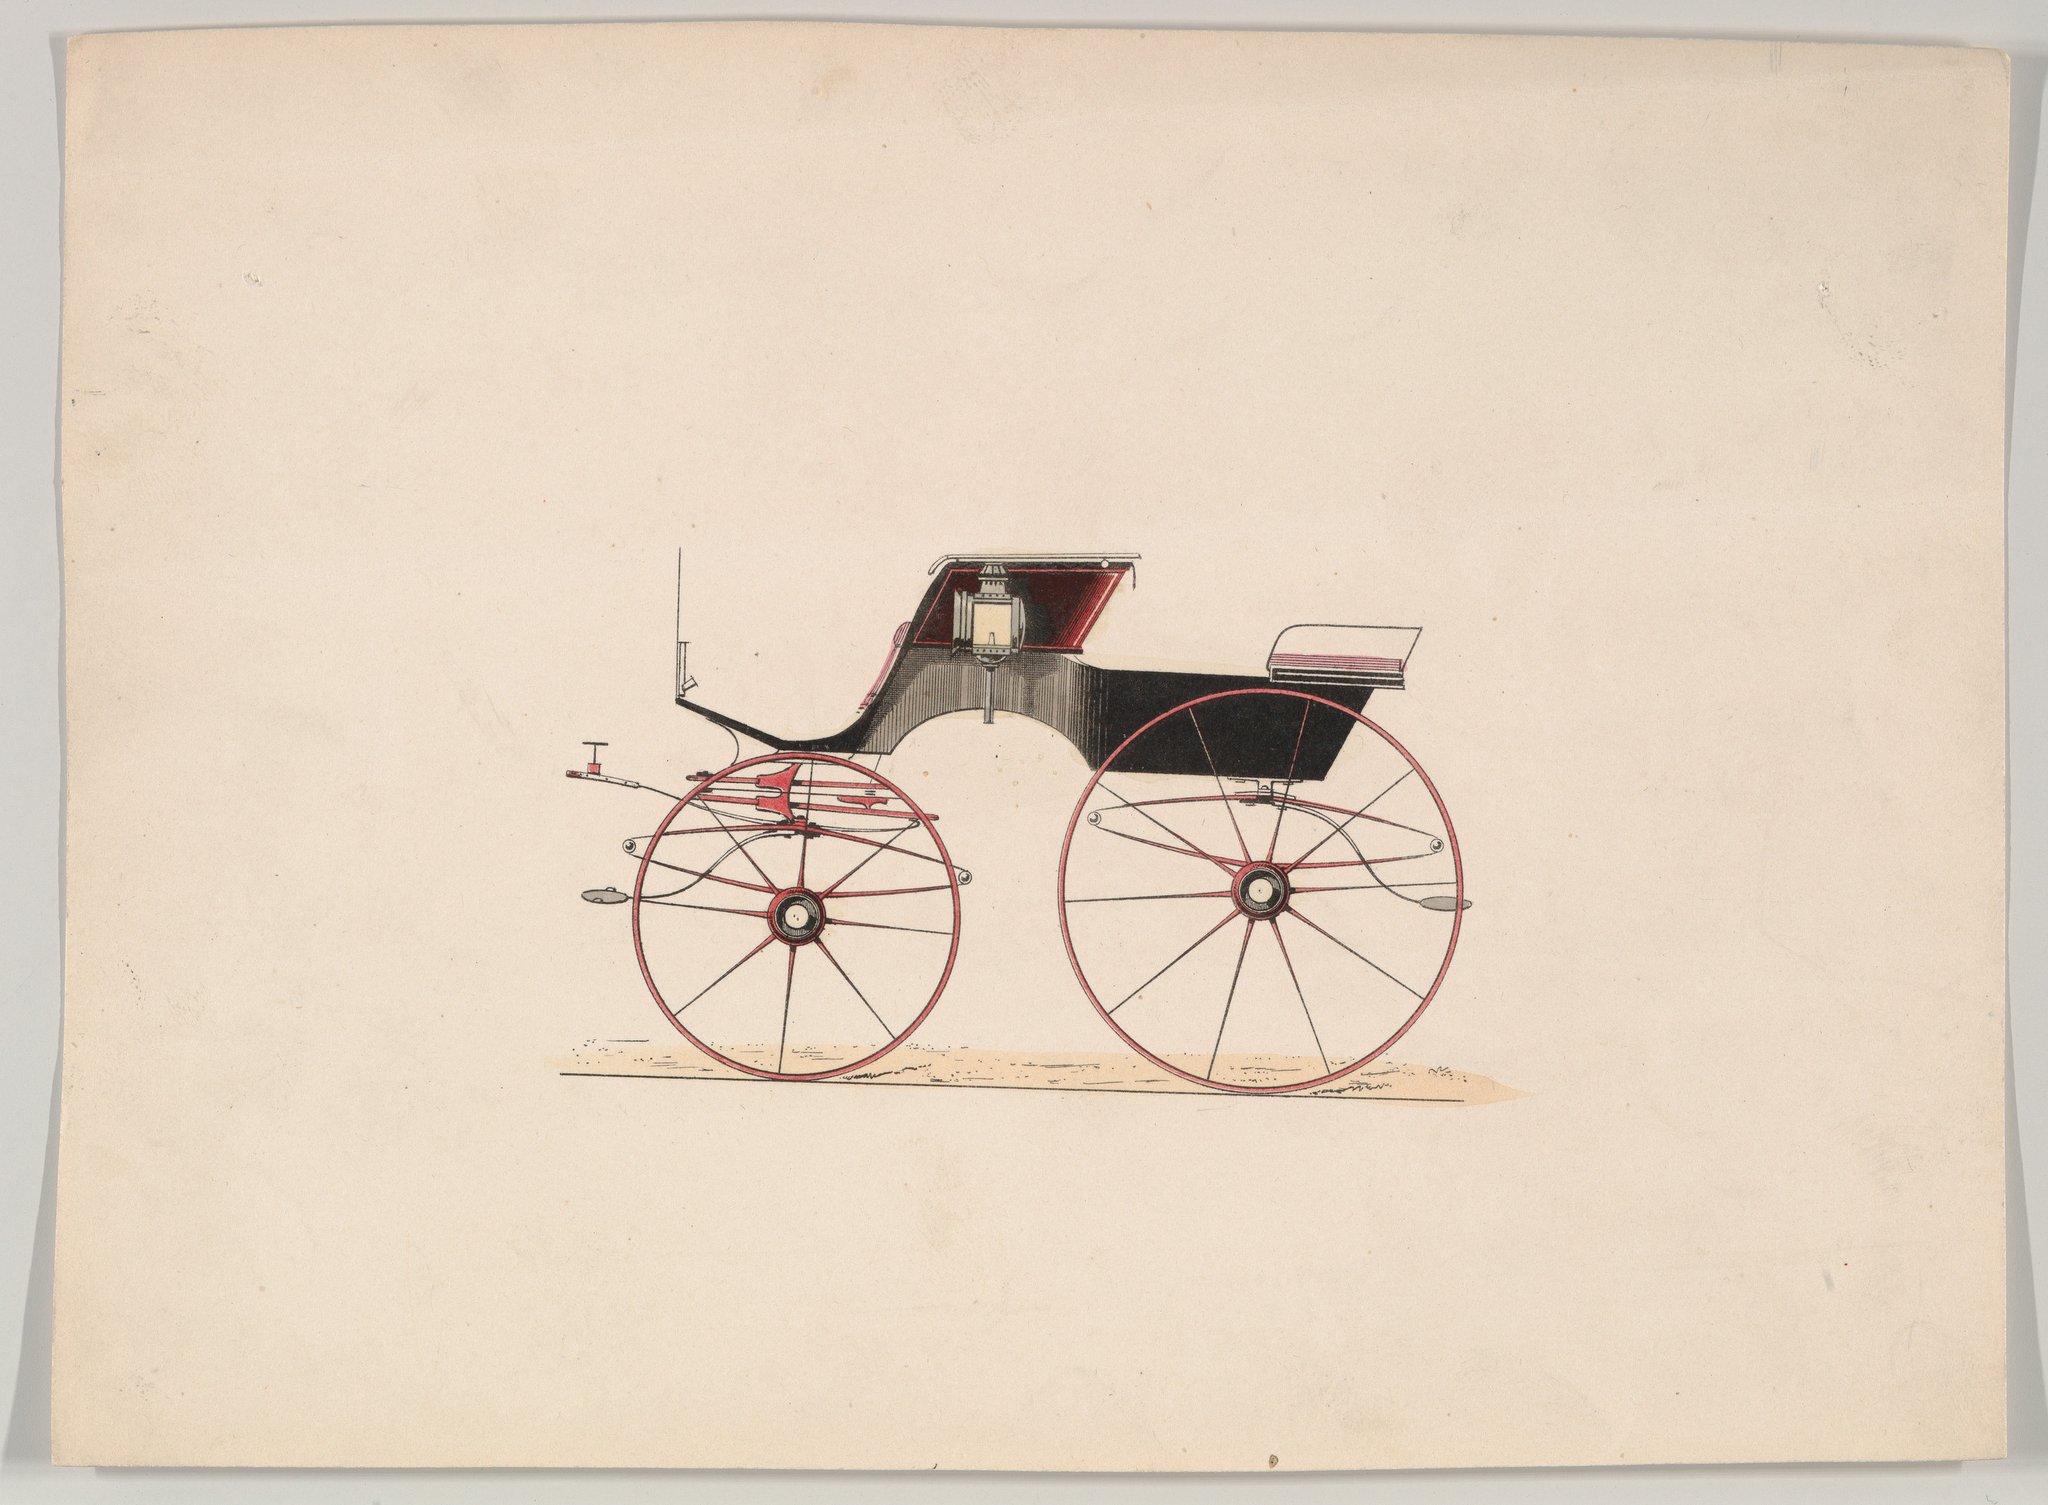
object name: drawing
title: T-Cart Phaeton (unnumbered)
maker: brewster & co.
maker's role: manufacturer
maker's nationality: american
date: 1850-1870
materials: gum arabic, ink, watercolor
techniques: pen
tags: carriages